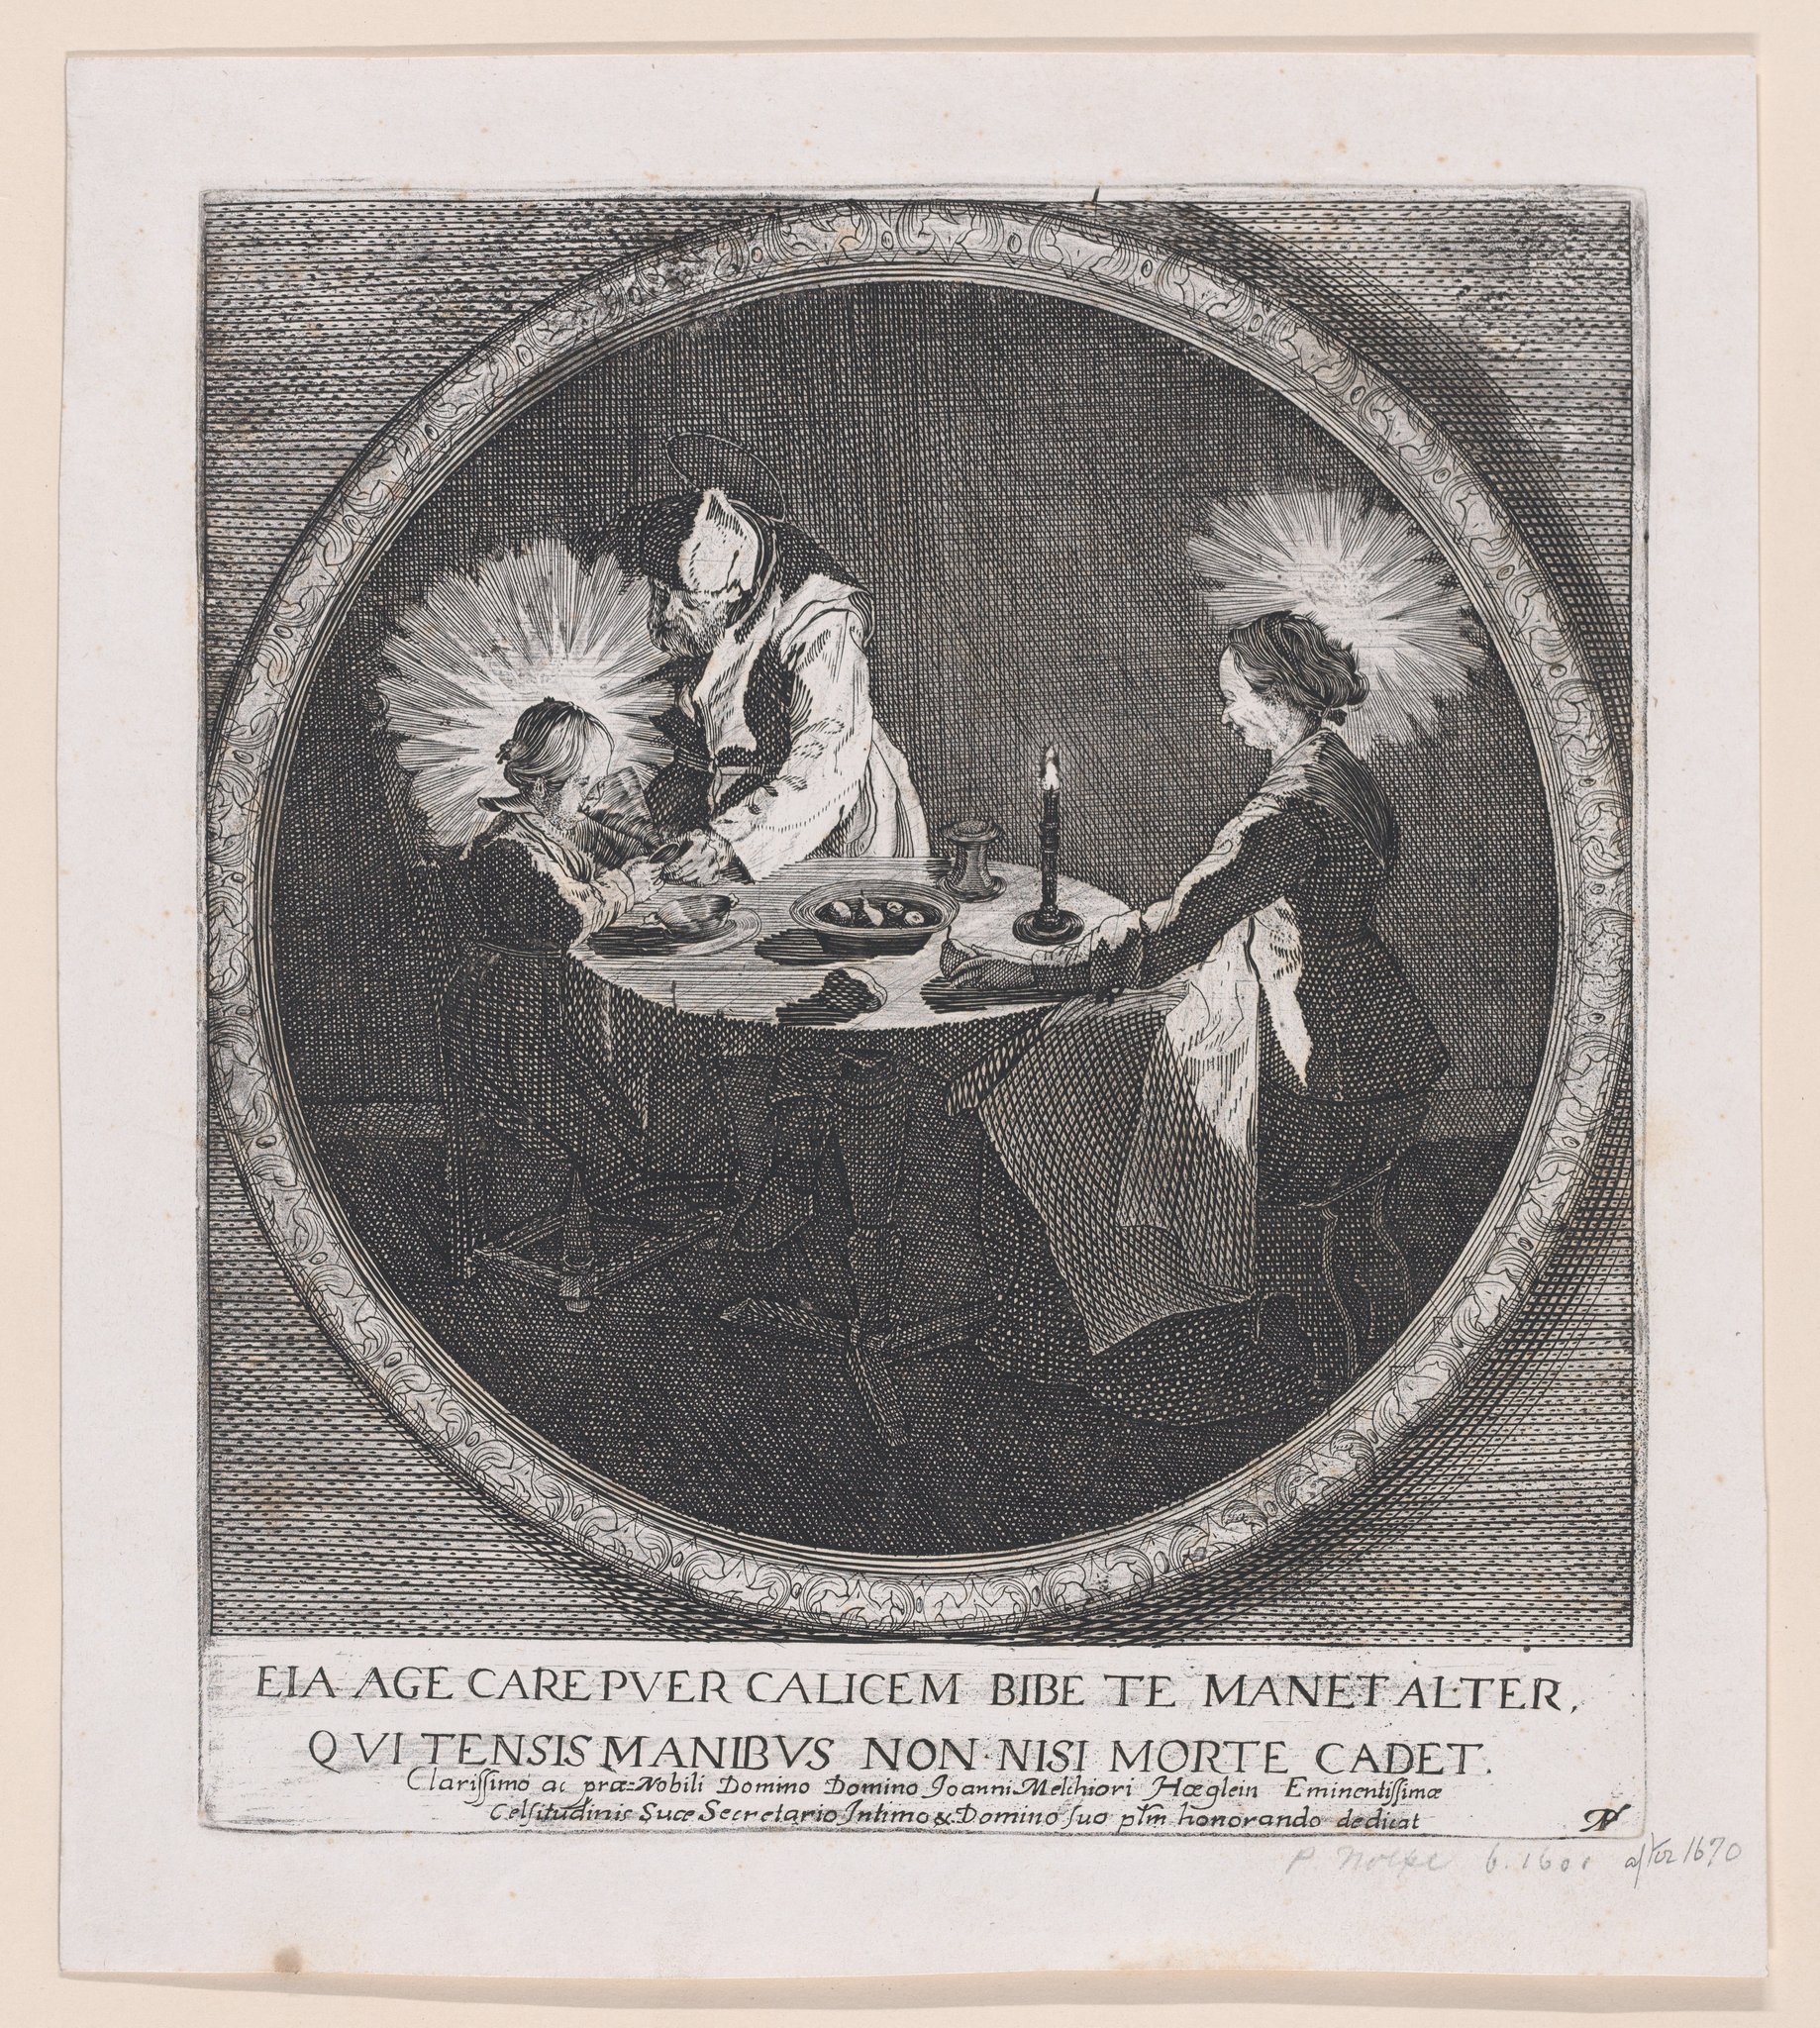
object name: print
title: Reverse Copy of Le Benedicite, estampe appelée aussi La Sainte Famille a Table et St. Joseph Faisant Boire L'Enfant Jésus (The Grace, also called The Holy Family at the Table and St. Joseph Giving the Christ Child a Drink)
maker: pieter nolpe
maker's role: artist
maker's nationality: dutch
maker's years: 1613-1614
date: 1601-1700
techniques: etching